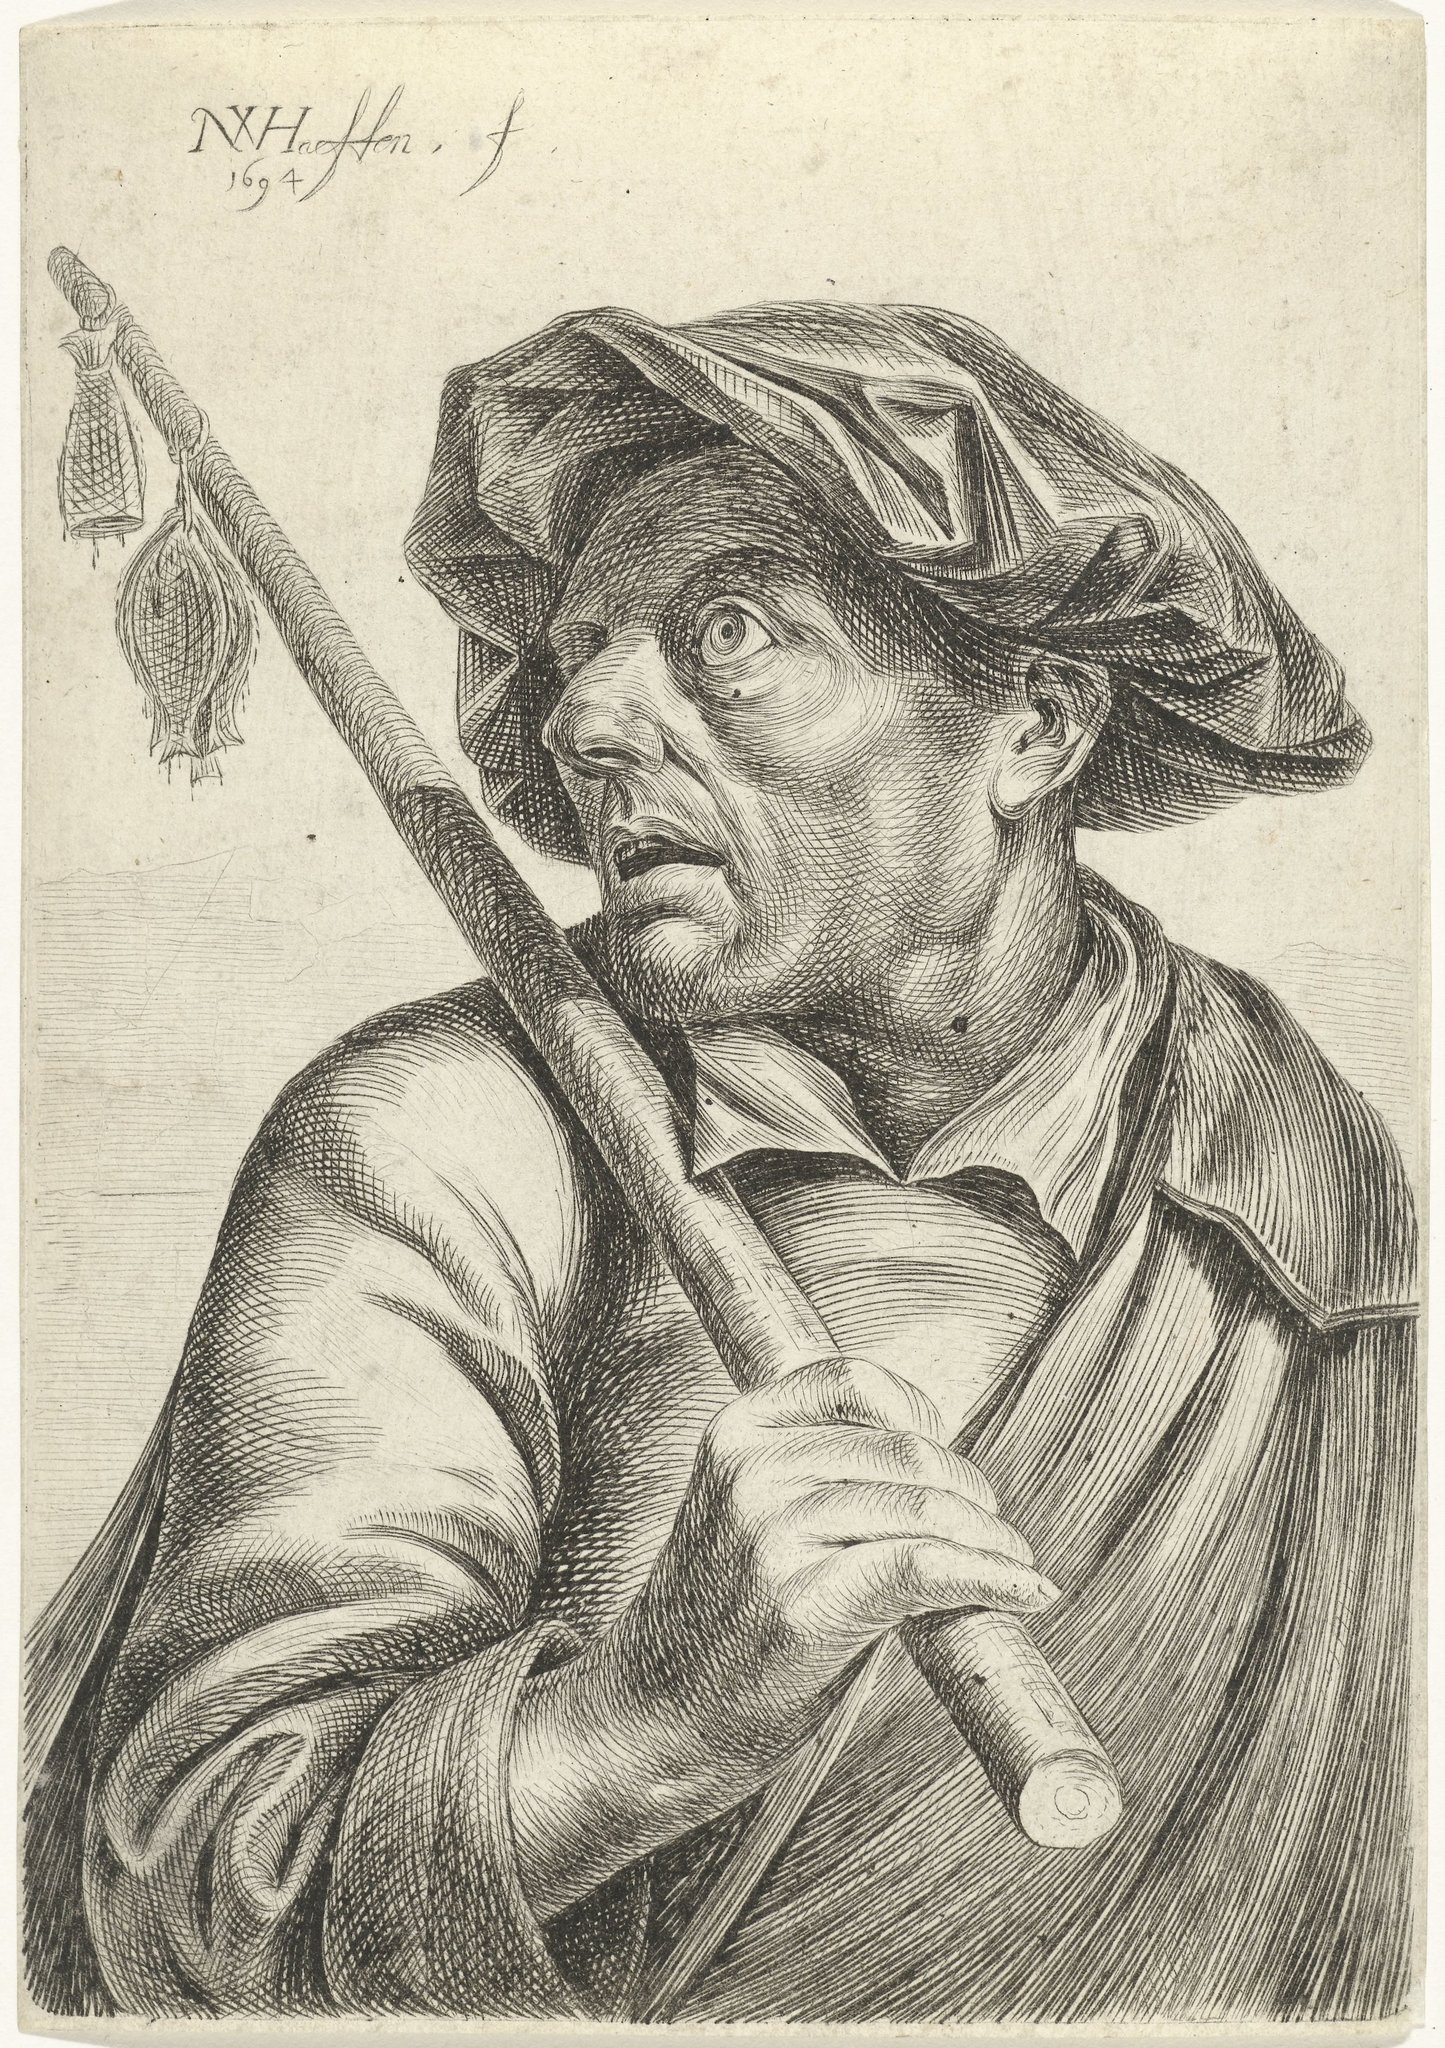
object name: print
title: Visser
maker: nicolaes van haeften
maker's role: draughtsman, painter, print maker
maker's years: 1653-1715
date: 1694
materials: paper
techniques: etching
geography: paris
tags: farmers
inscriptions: collector's mark: Lugt 2228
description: Man ten halven lijve met een stok over zijn schouder waaraan twee vissen hangen.